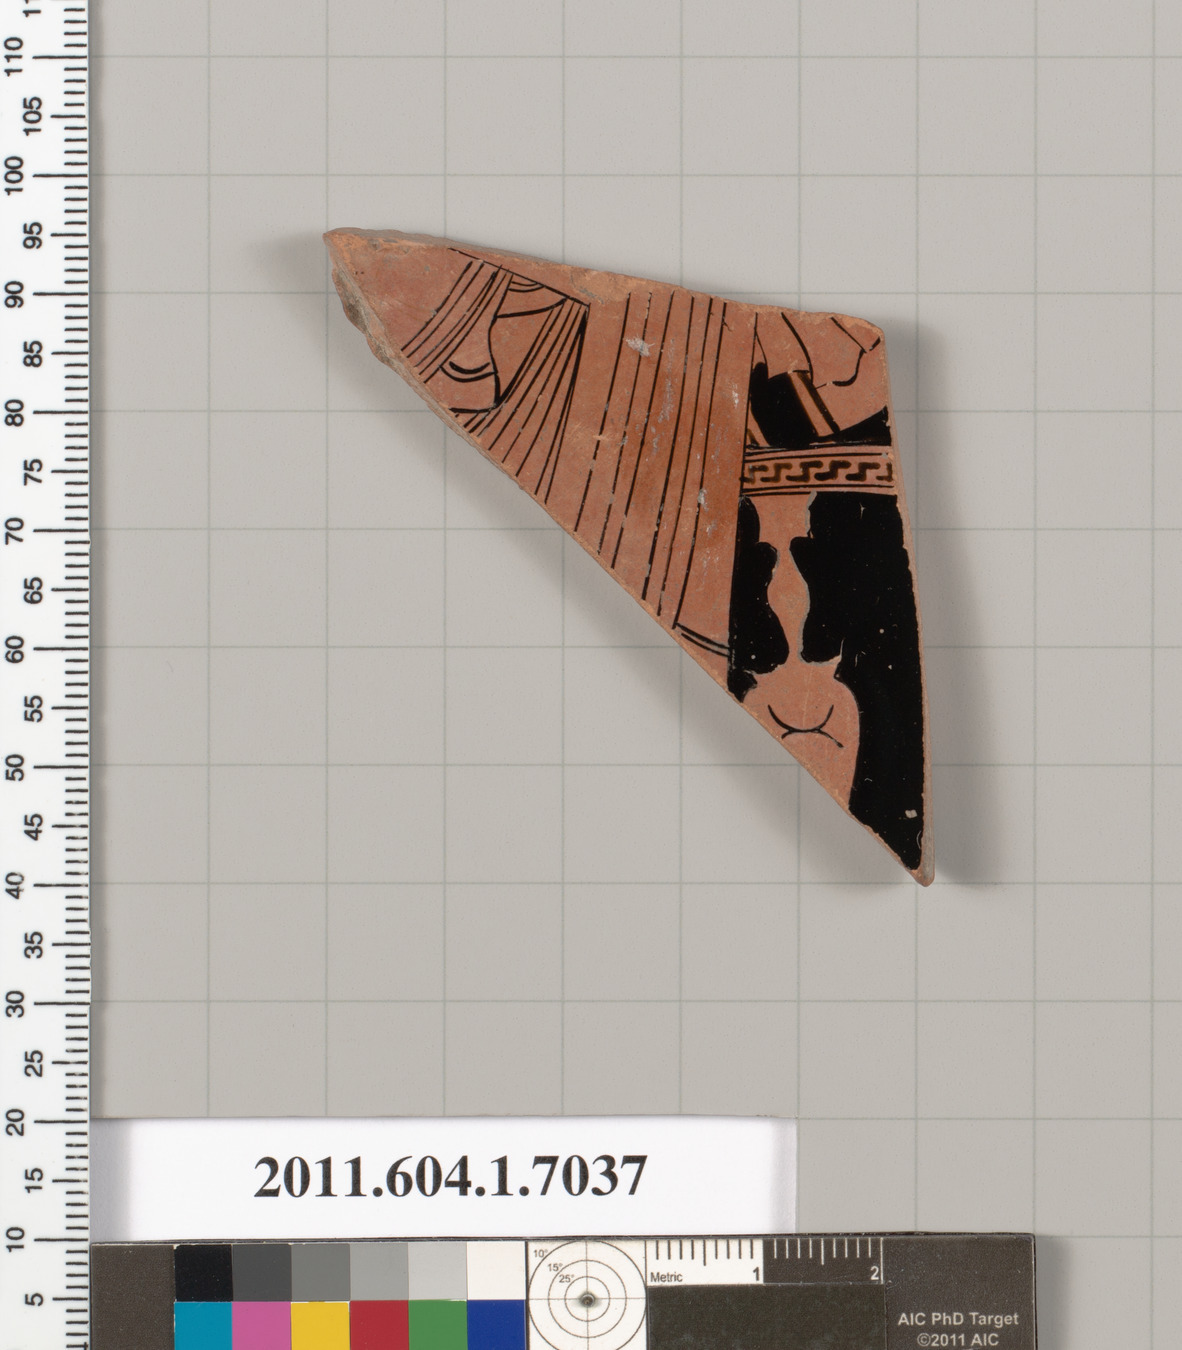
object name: kylix fragment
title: Terracotta fragment of a kylix (drinking cup)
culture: greek, attic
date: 500-480 BCE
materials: terracotta